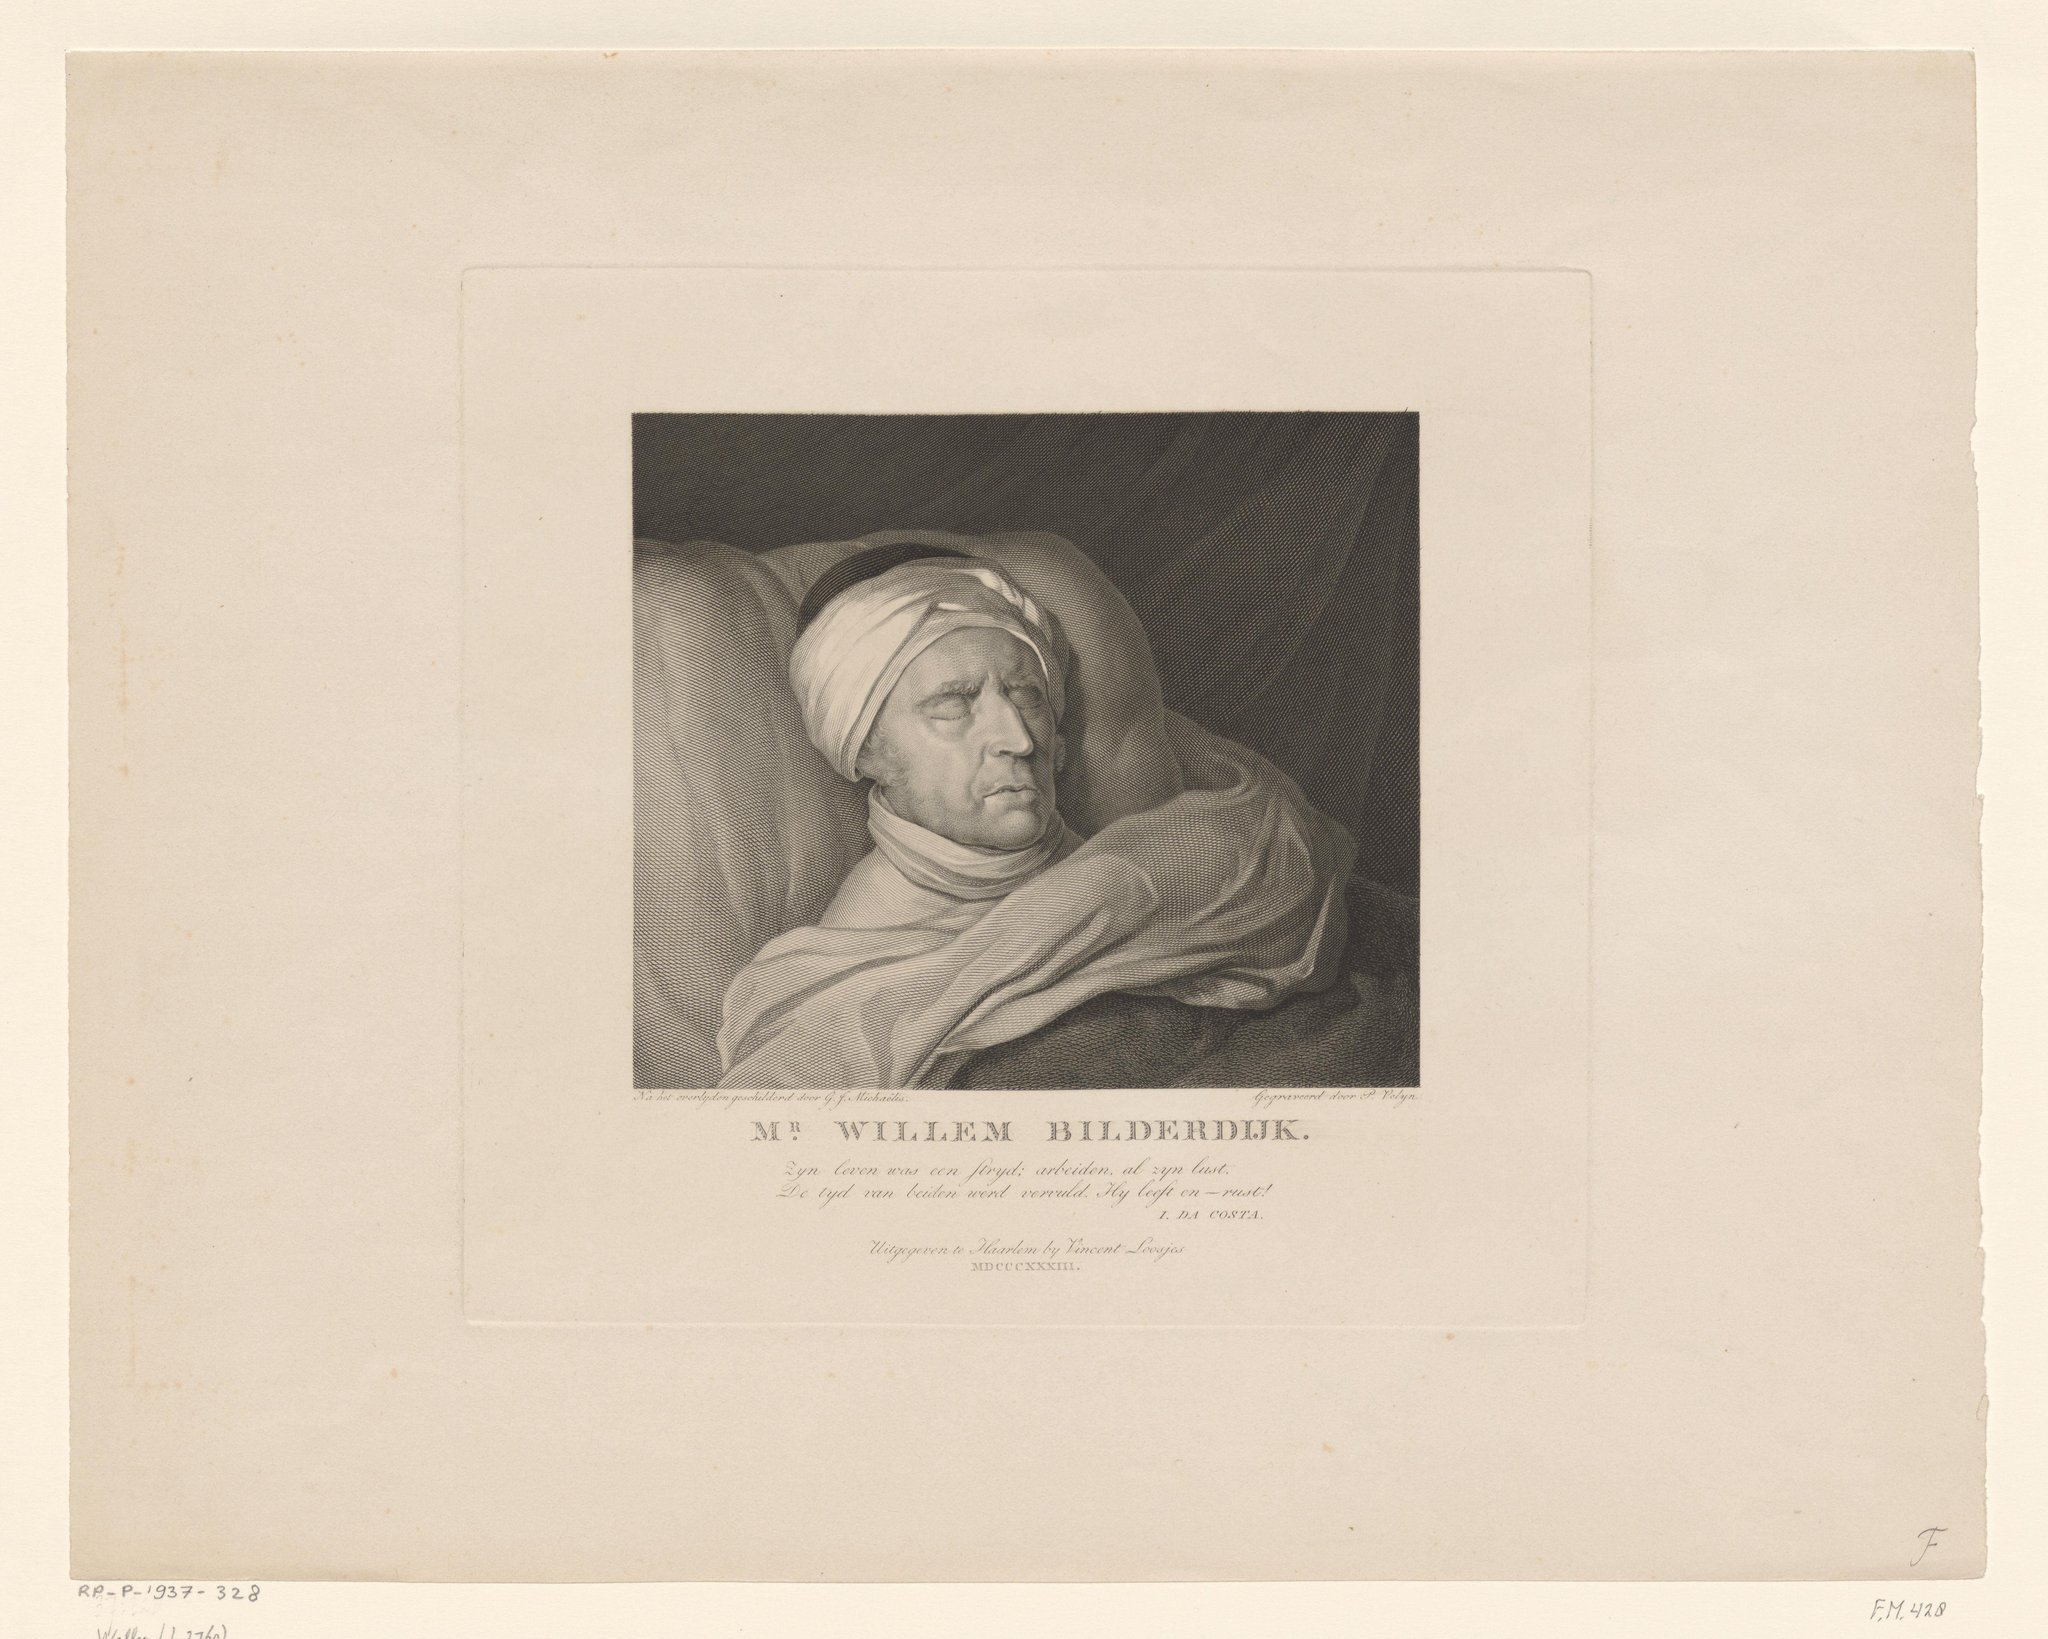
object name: print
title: Willem Bilderdijk op zijn doodsbed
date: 1833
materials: paper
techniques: engraving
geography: haarlem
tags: amsterdam, print maker, willem bilderdijk, deathbed, artist on his deathbed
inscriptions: collector's mark: Lugt 2228, collector's mark: Lugt 2760